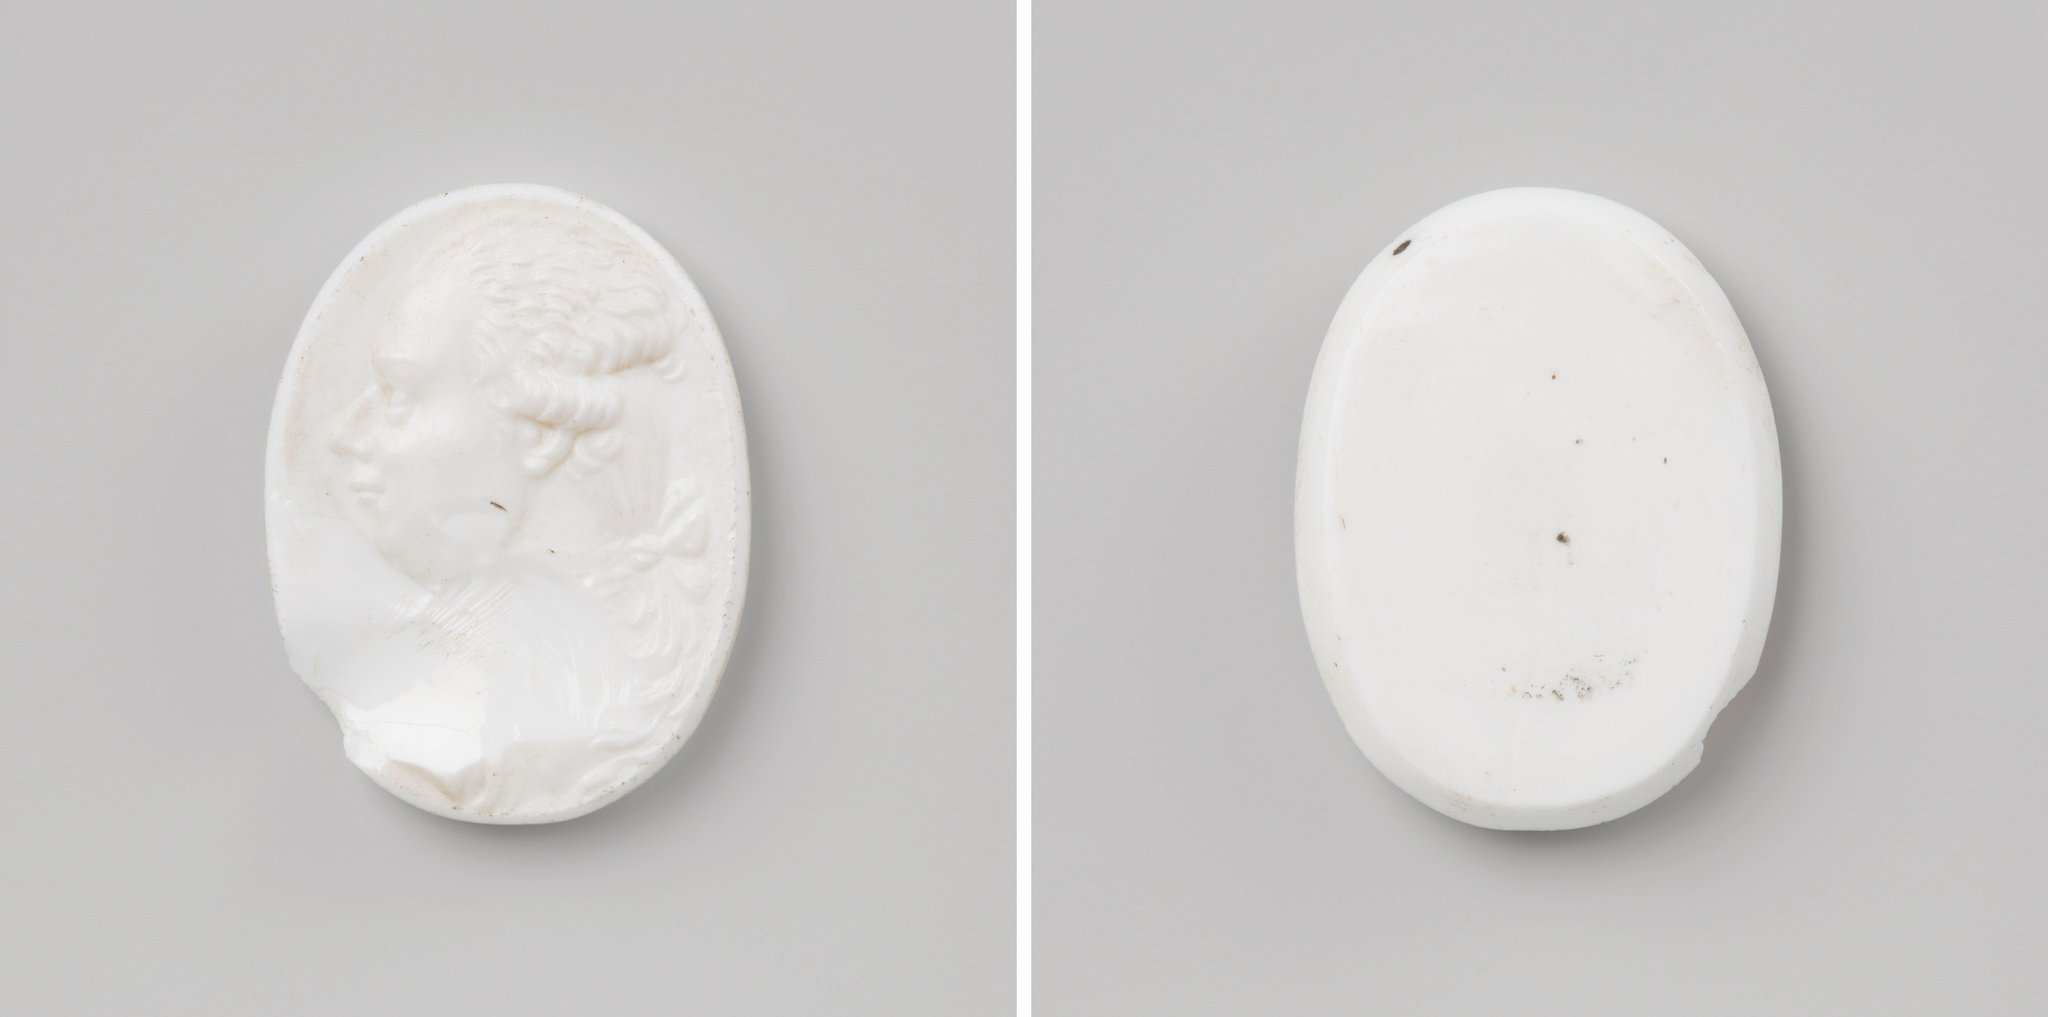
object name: plaque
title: Willem V, prins van Oranje-Nassau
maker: Anonymous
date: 1785-1795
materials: porcelain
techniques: firing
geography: netherlands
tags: the hague, william v (prince of orange)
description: eenzijdige, ovale plaquette. Voorzijde: borststuk man binnen. Keerzijde: blanco